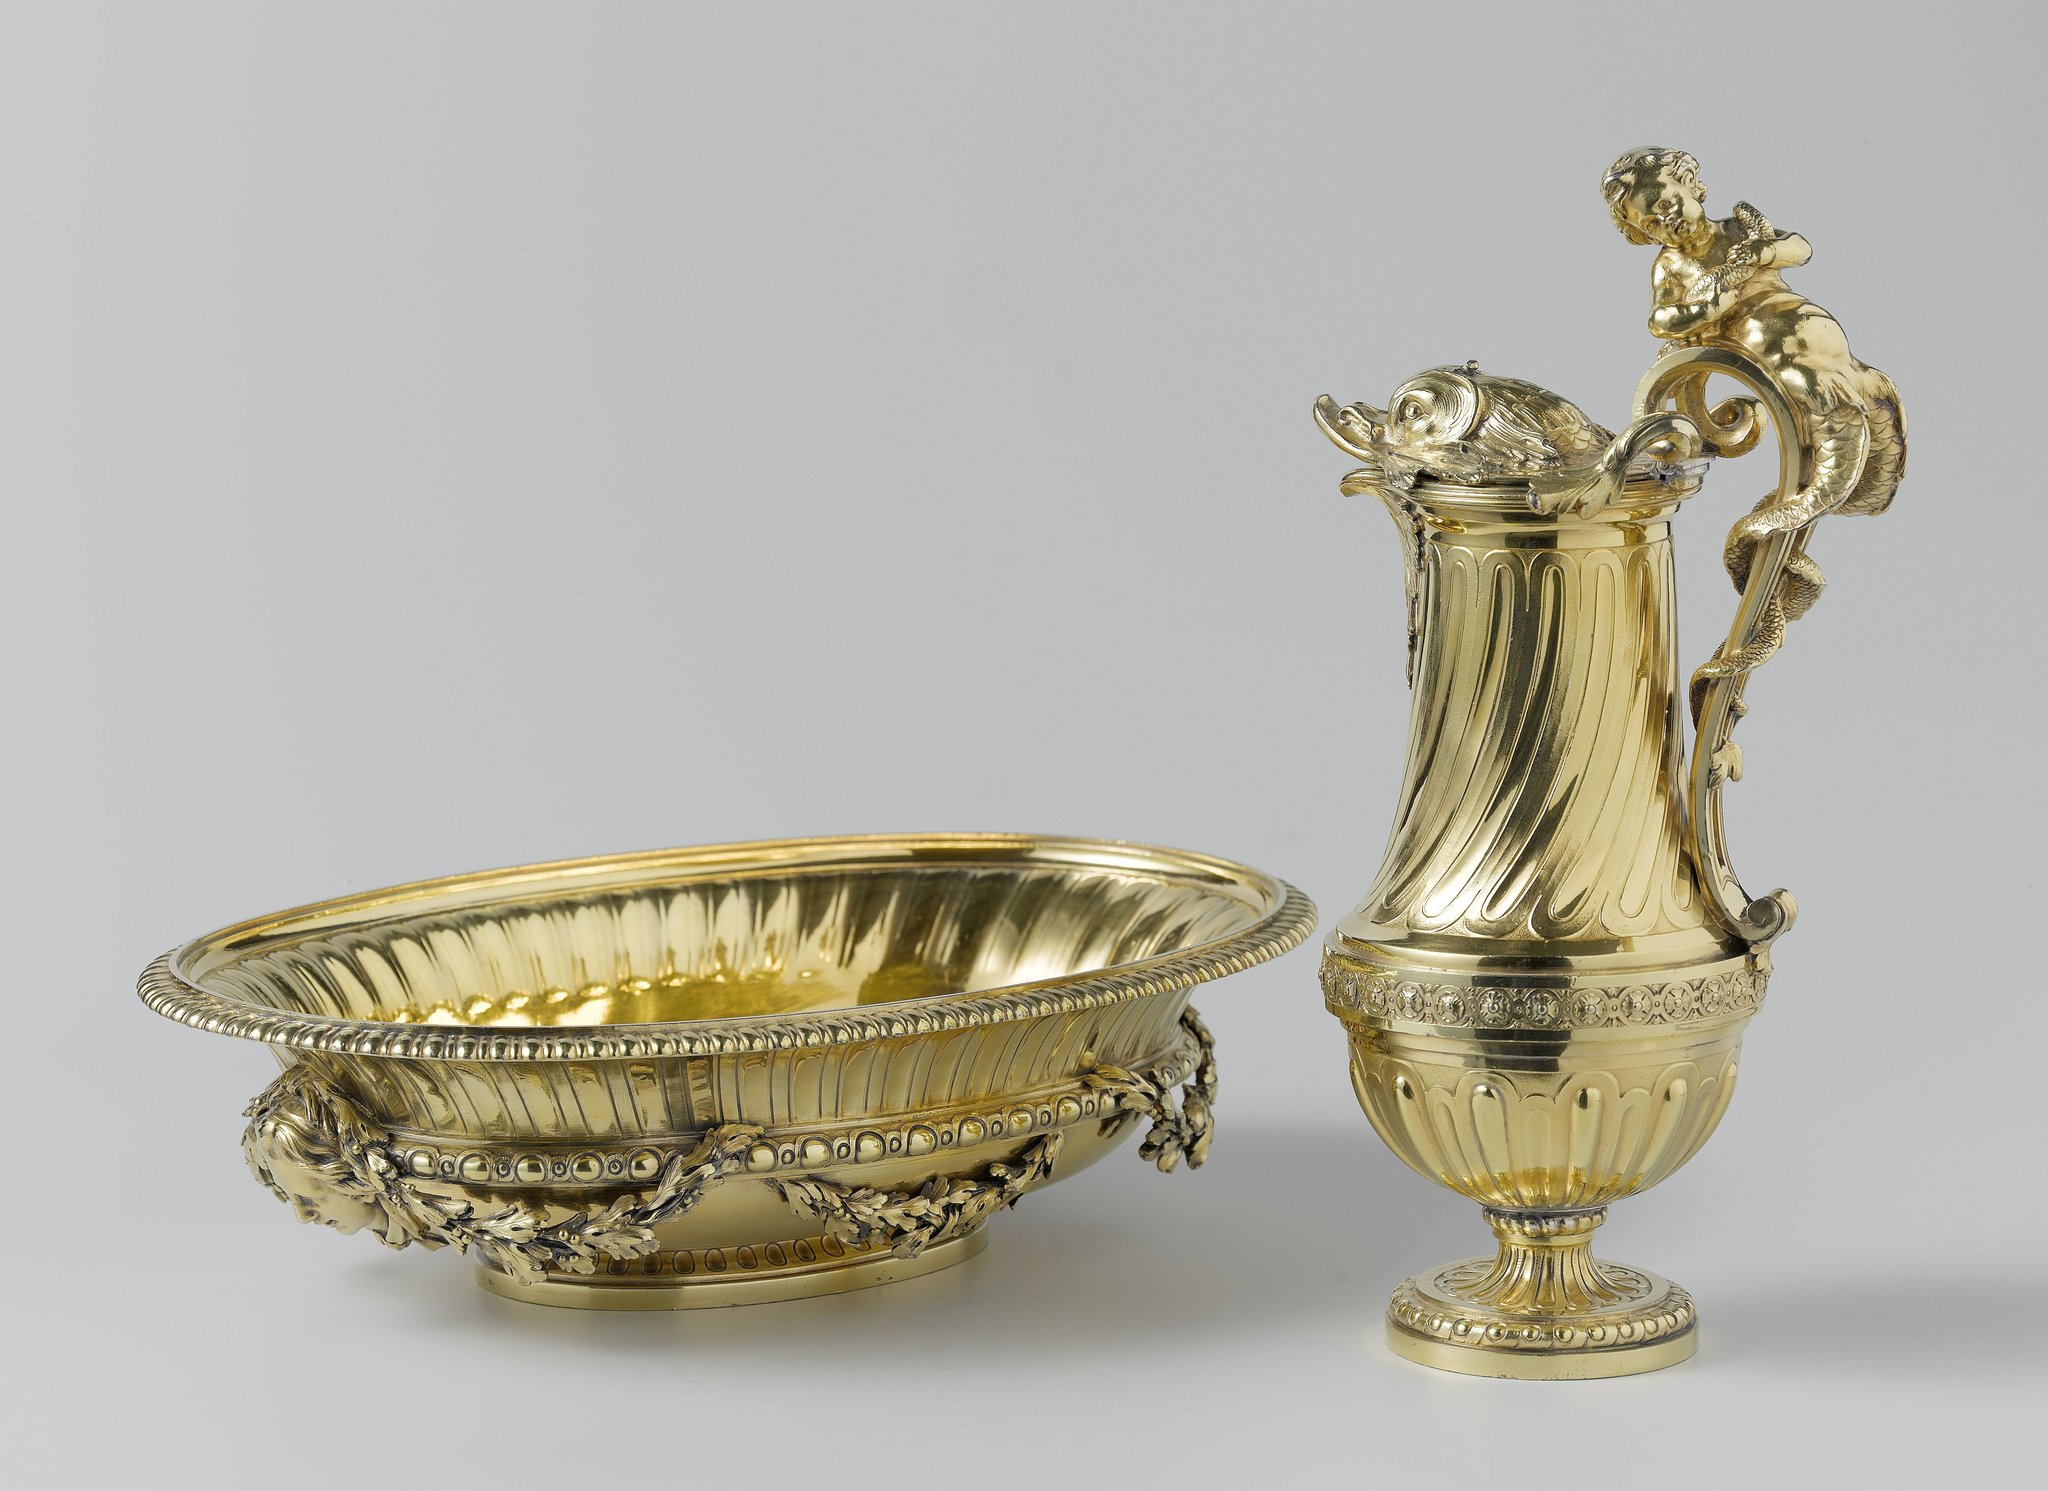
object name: bekken schaal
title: Ewer and basin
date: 1765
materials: silver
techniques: gilding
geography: paris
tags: ornament ~ festoon, garland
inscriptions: date letter, duty mark, duty mark, duty mark, duty mark, date letter, duty mark, maker's mark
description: The ewer and basin were part of a toilet service that King Charles III of Spain gave Marie Louise of Parma, who married his eldest son in 1765. These are the only parts of the service that have been preserved. The ewer was used to pour water into the basin for the lady’s toilet.